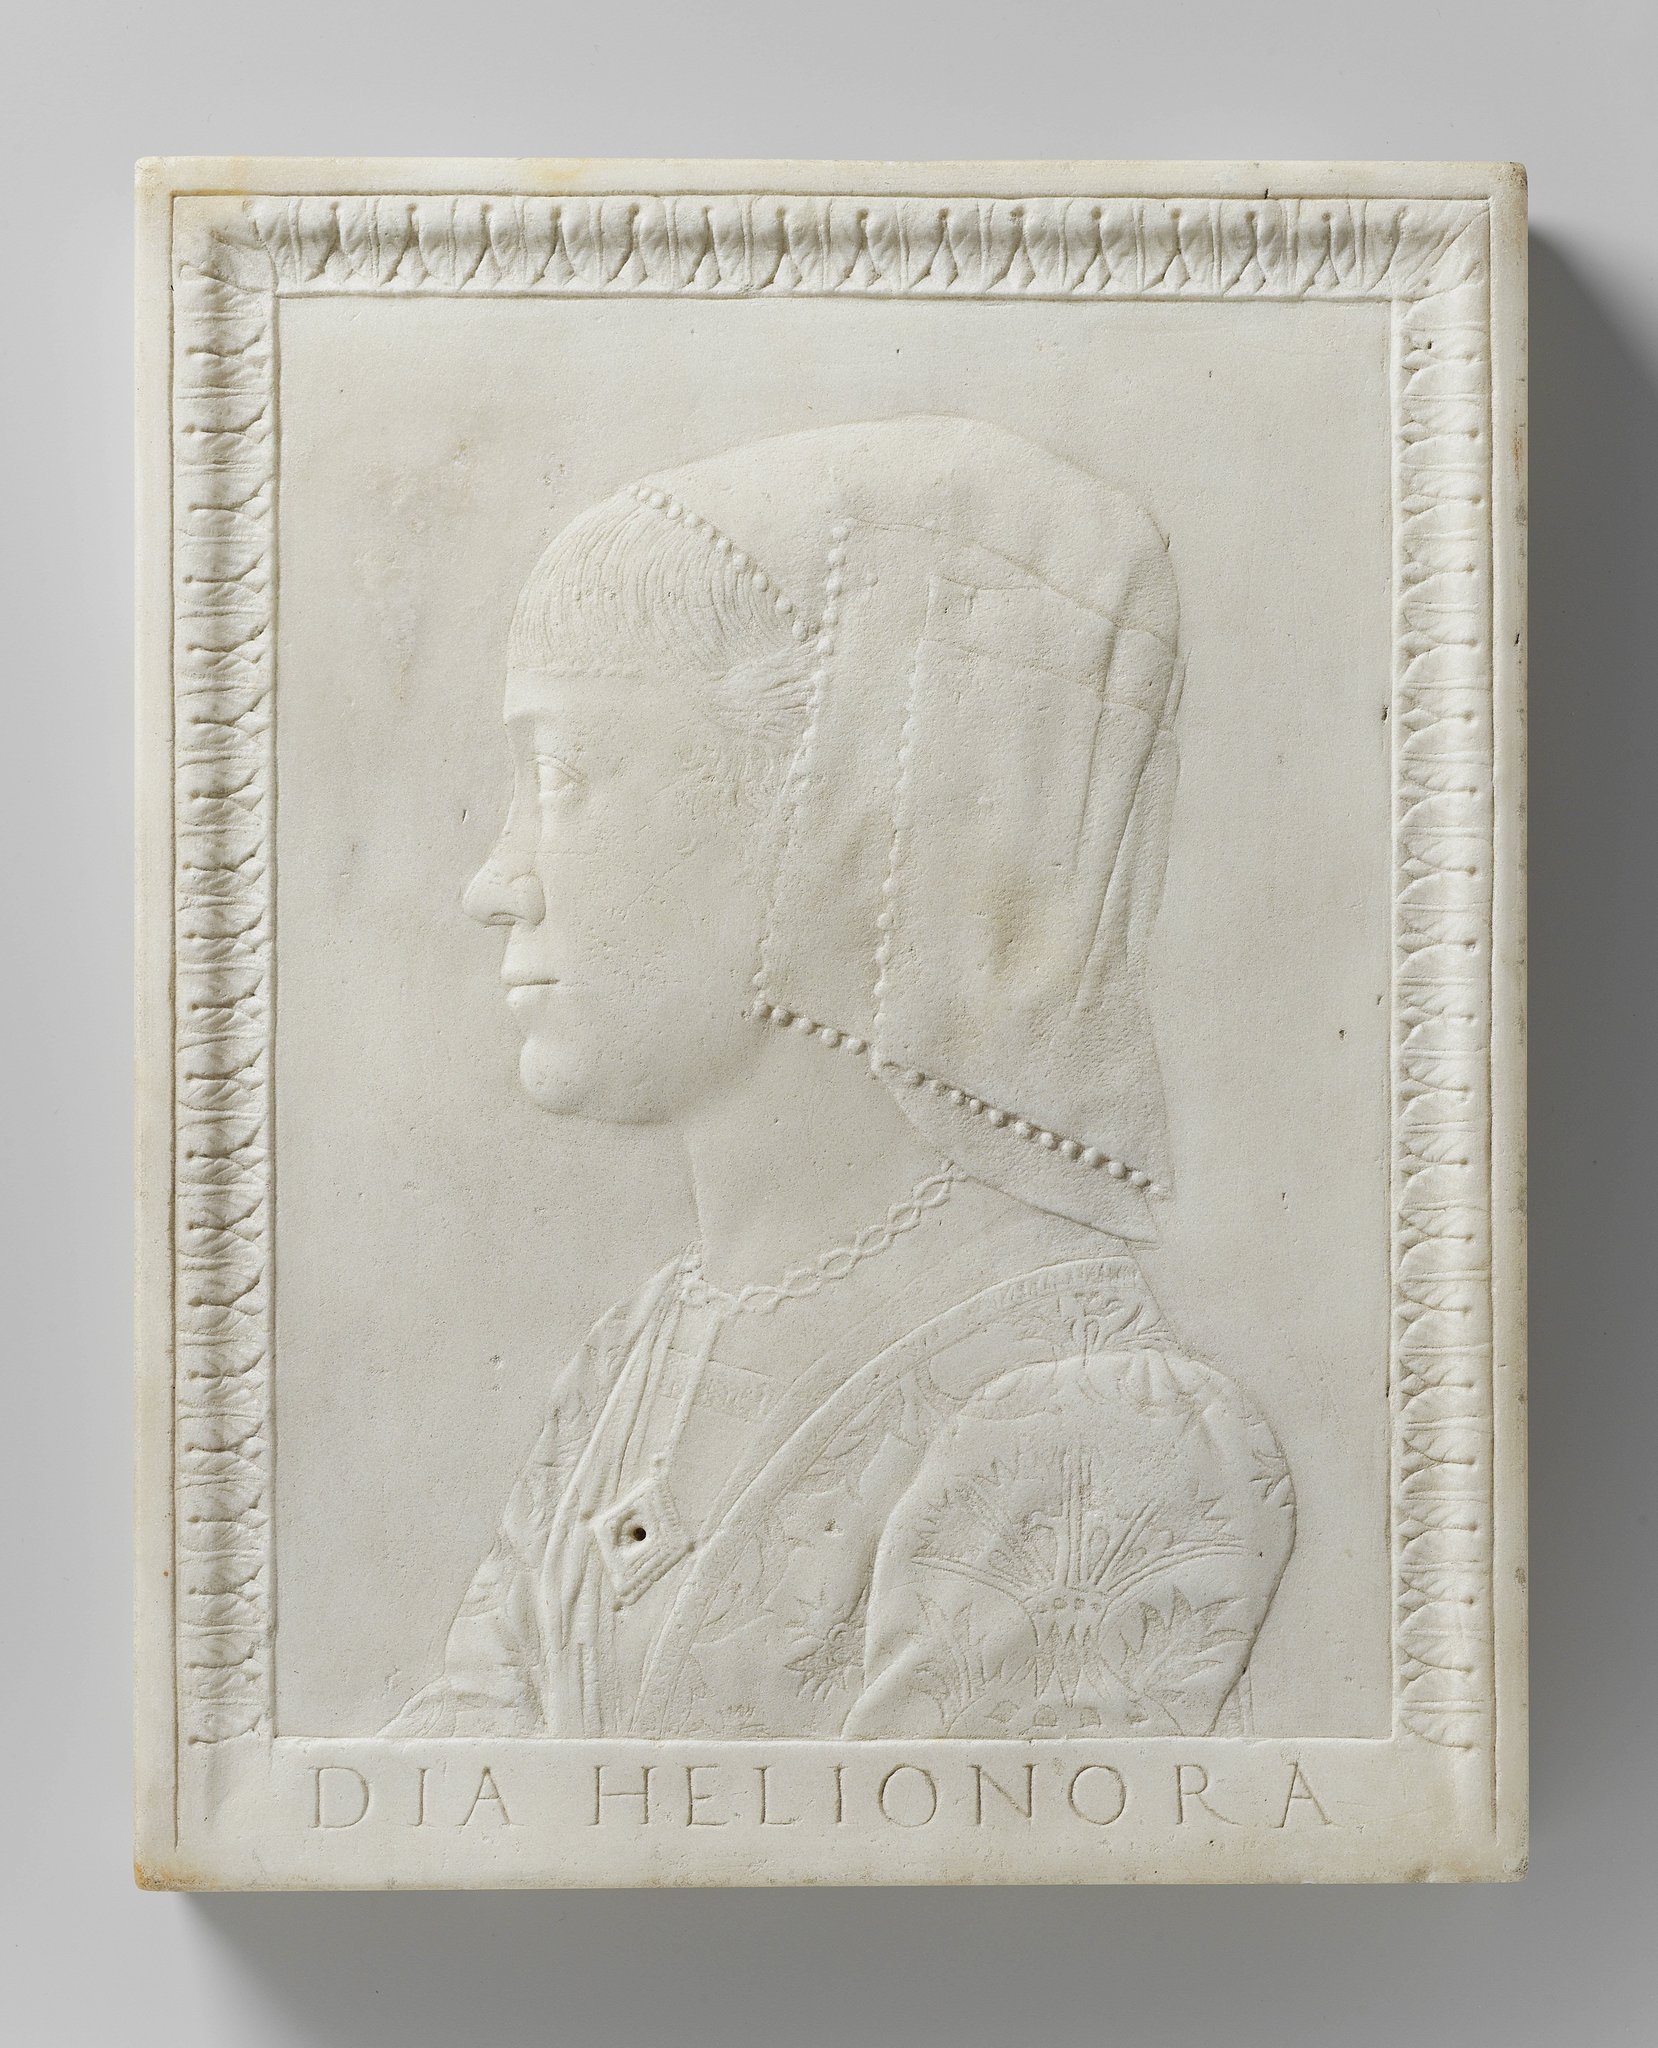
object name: sculpture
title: Eleanora of Aragon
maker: giovanni cristoforo romano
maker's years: 1460-1512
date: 1473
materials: marble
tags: naples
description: While Eleanora of Aragon may not be portrayed here as a ravishing beauty, she is certainly not ugly. In any case, she can hardly be recognized as the stocky Duchess of Ferrara with skin more brown than white, as she was described by a contemporary. The sculptor clearly idealized her. Her neck is elegantly long and the white marble automatically lends her the then desired pallor.